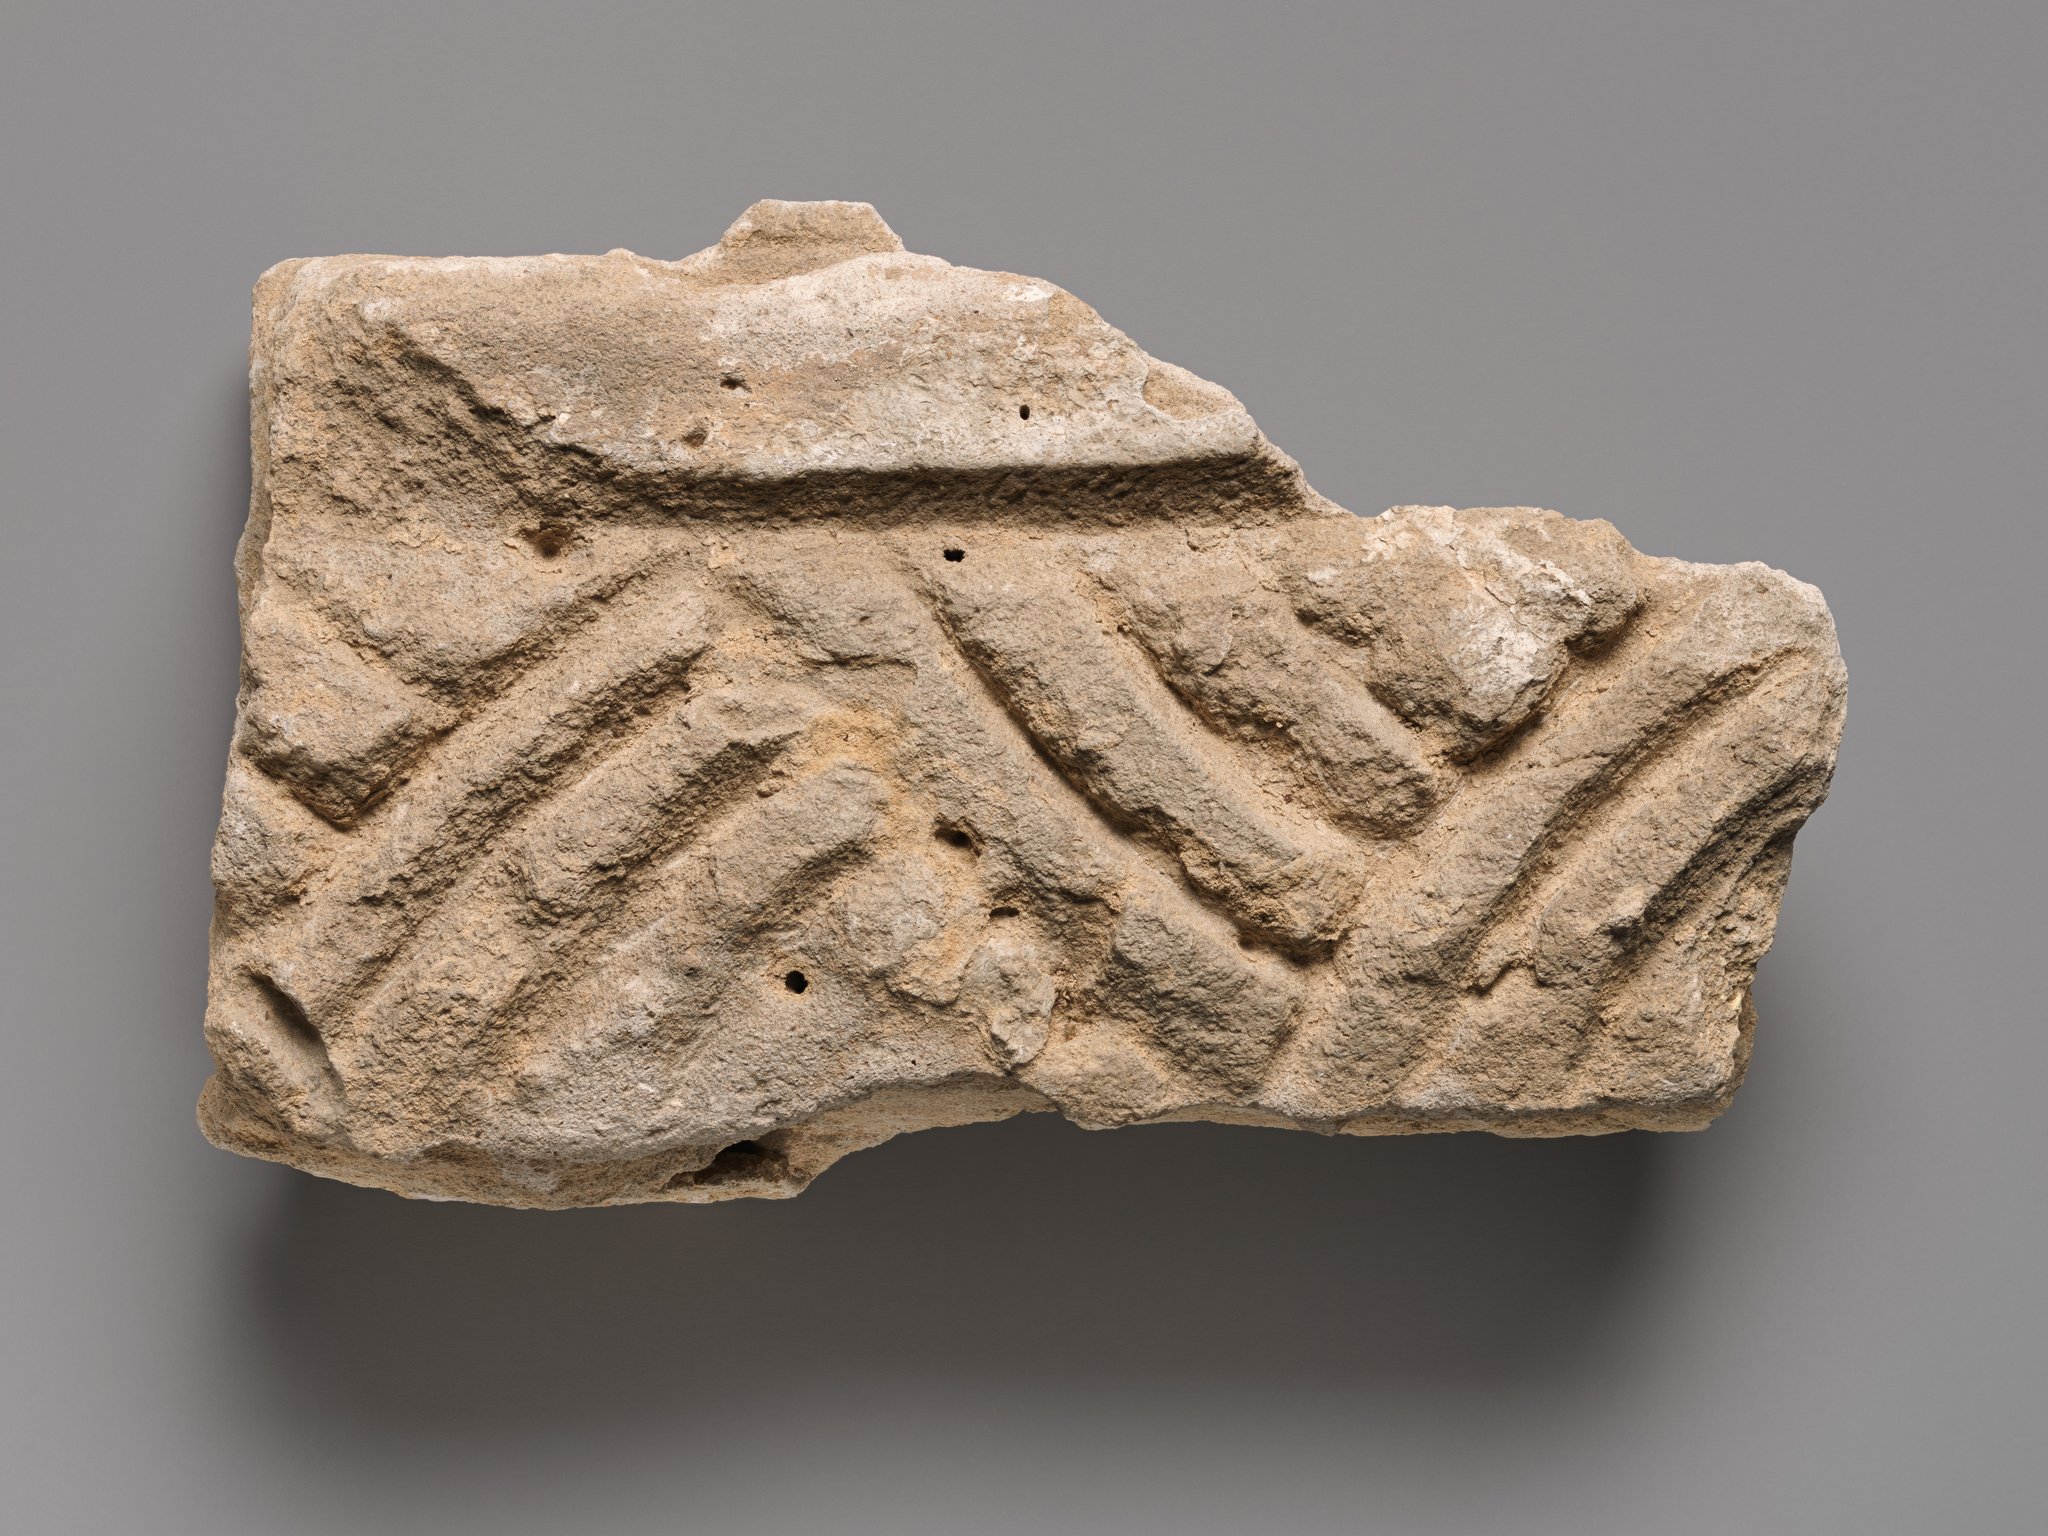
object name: relief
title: Relief fragment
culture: sasanian or islamic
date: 501-800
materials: plaster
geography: mesopotamia